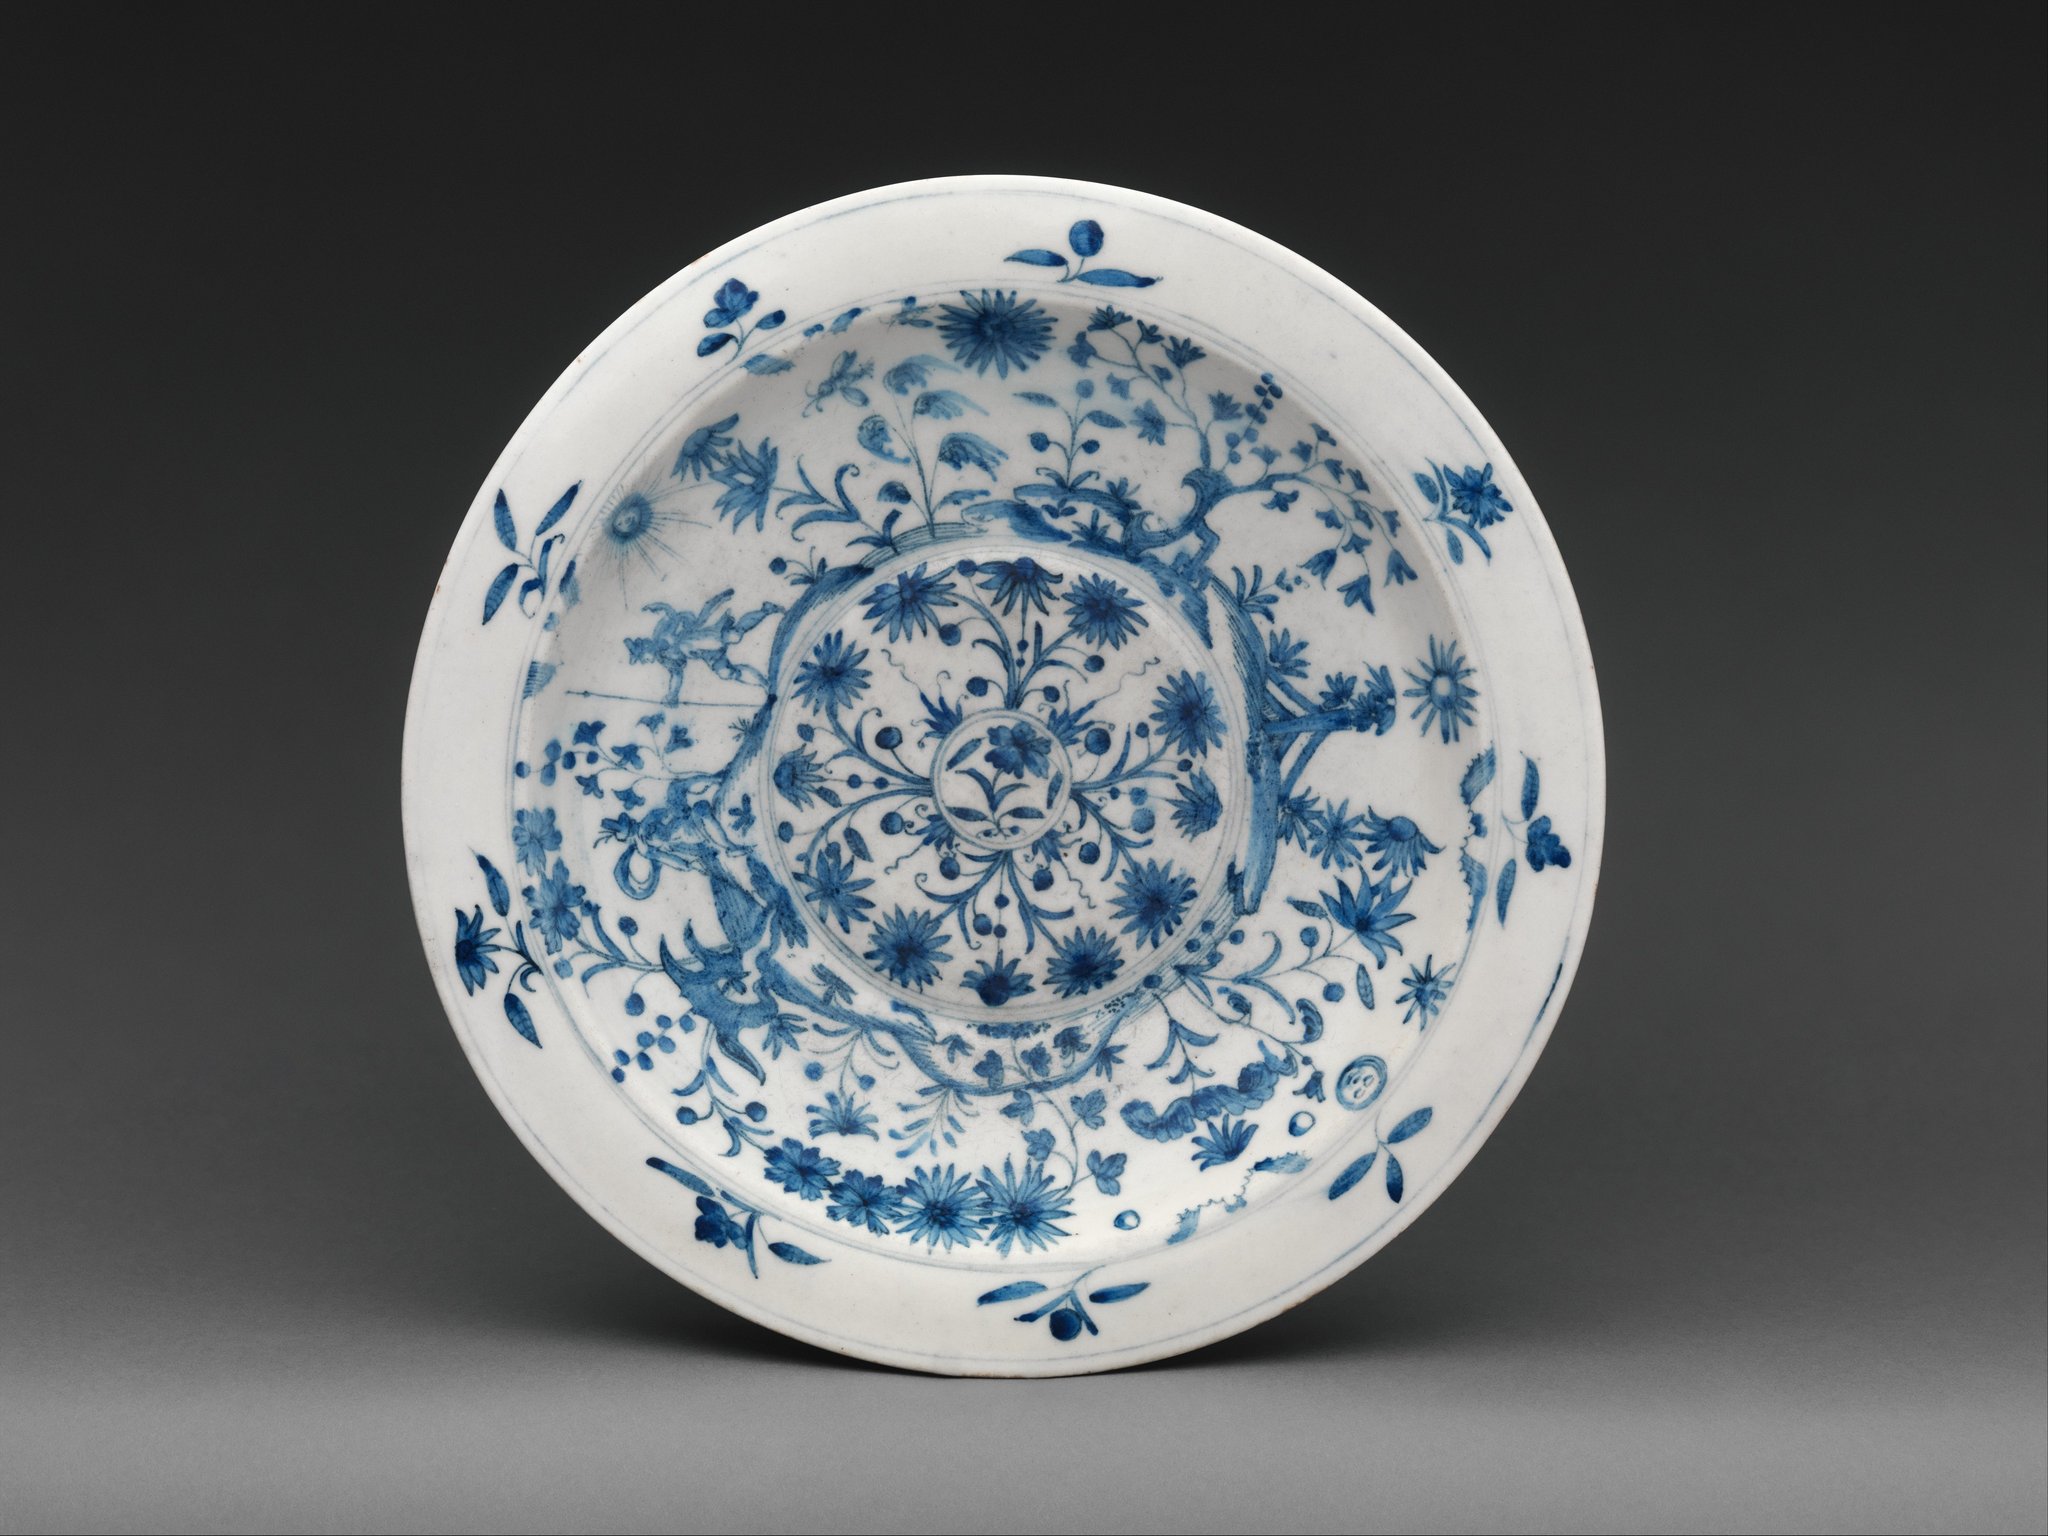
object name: dish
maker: medici porcelain manufactory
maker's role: manufactory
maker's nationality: italian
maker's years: 1570-1592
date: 1575-1587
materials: soft paste porcelain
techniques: underglaze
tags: flowers